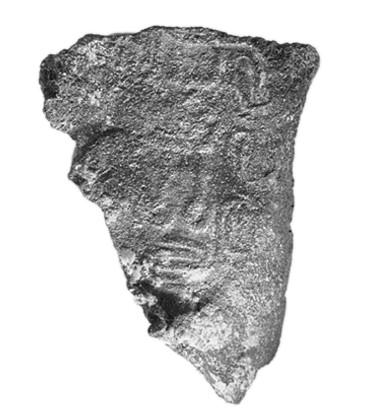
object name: sealing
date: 1981-1640 BCE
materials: mud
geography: egypt